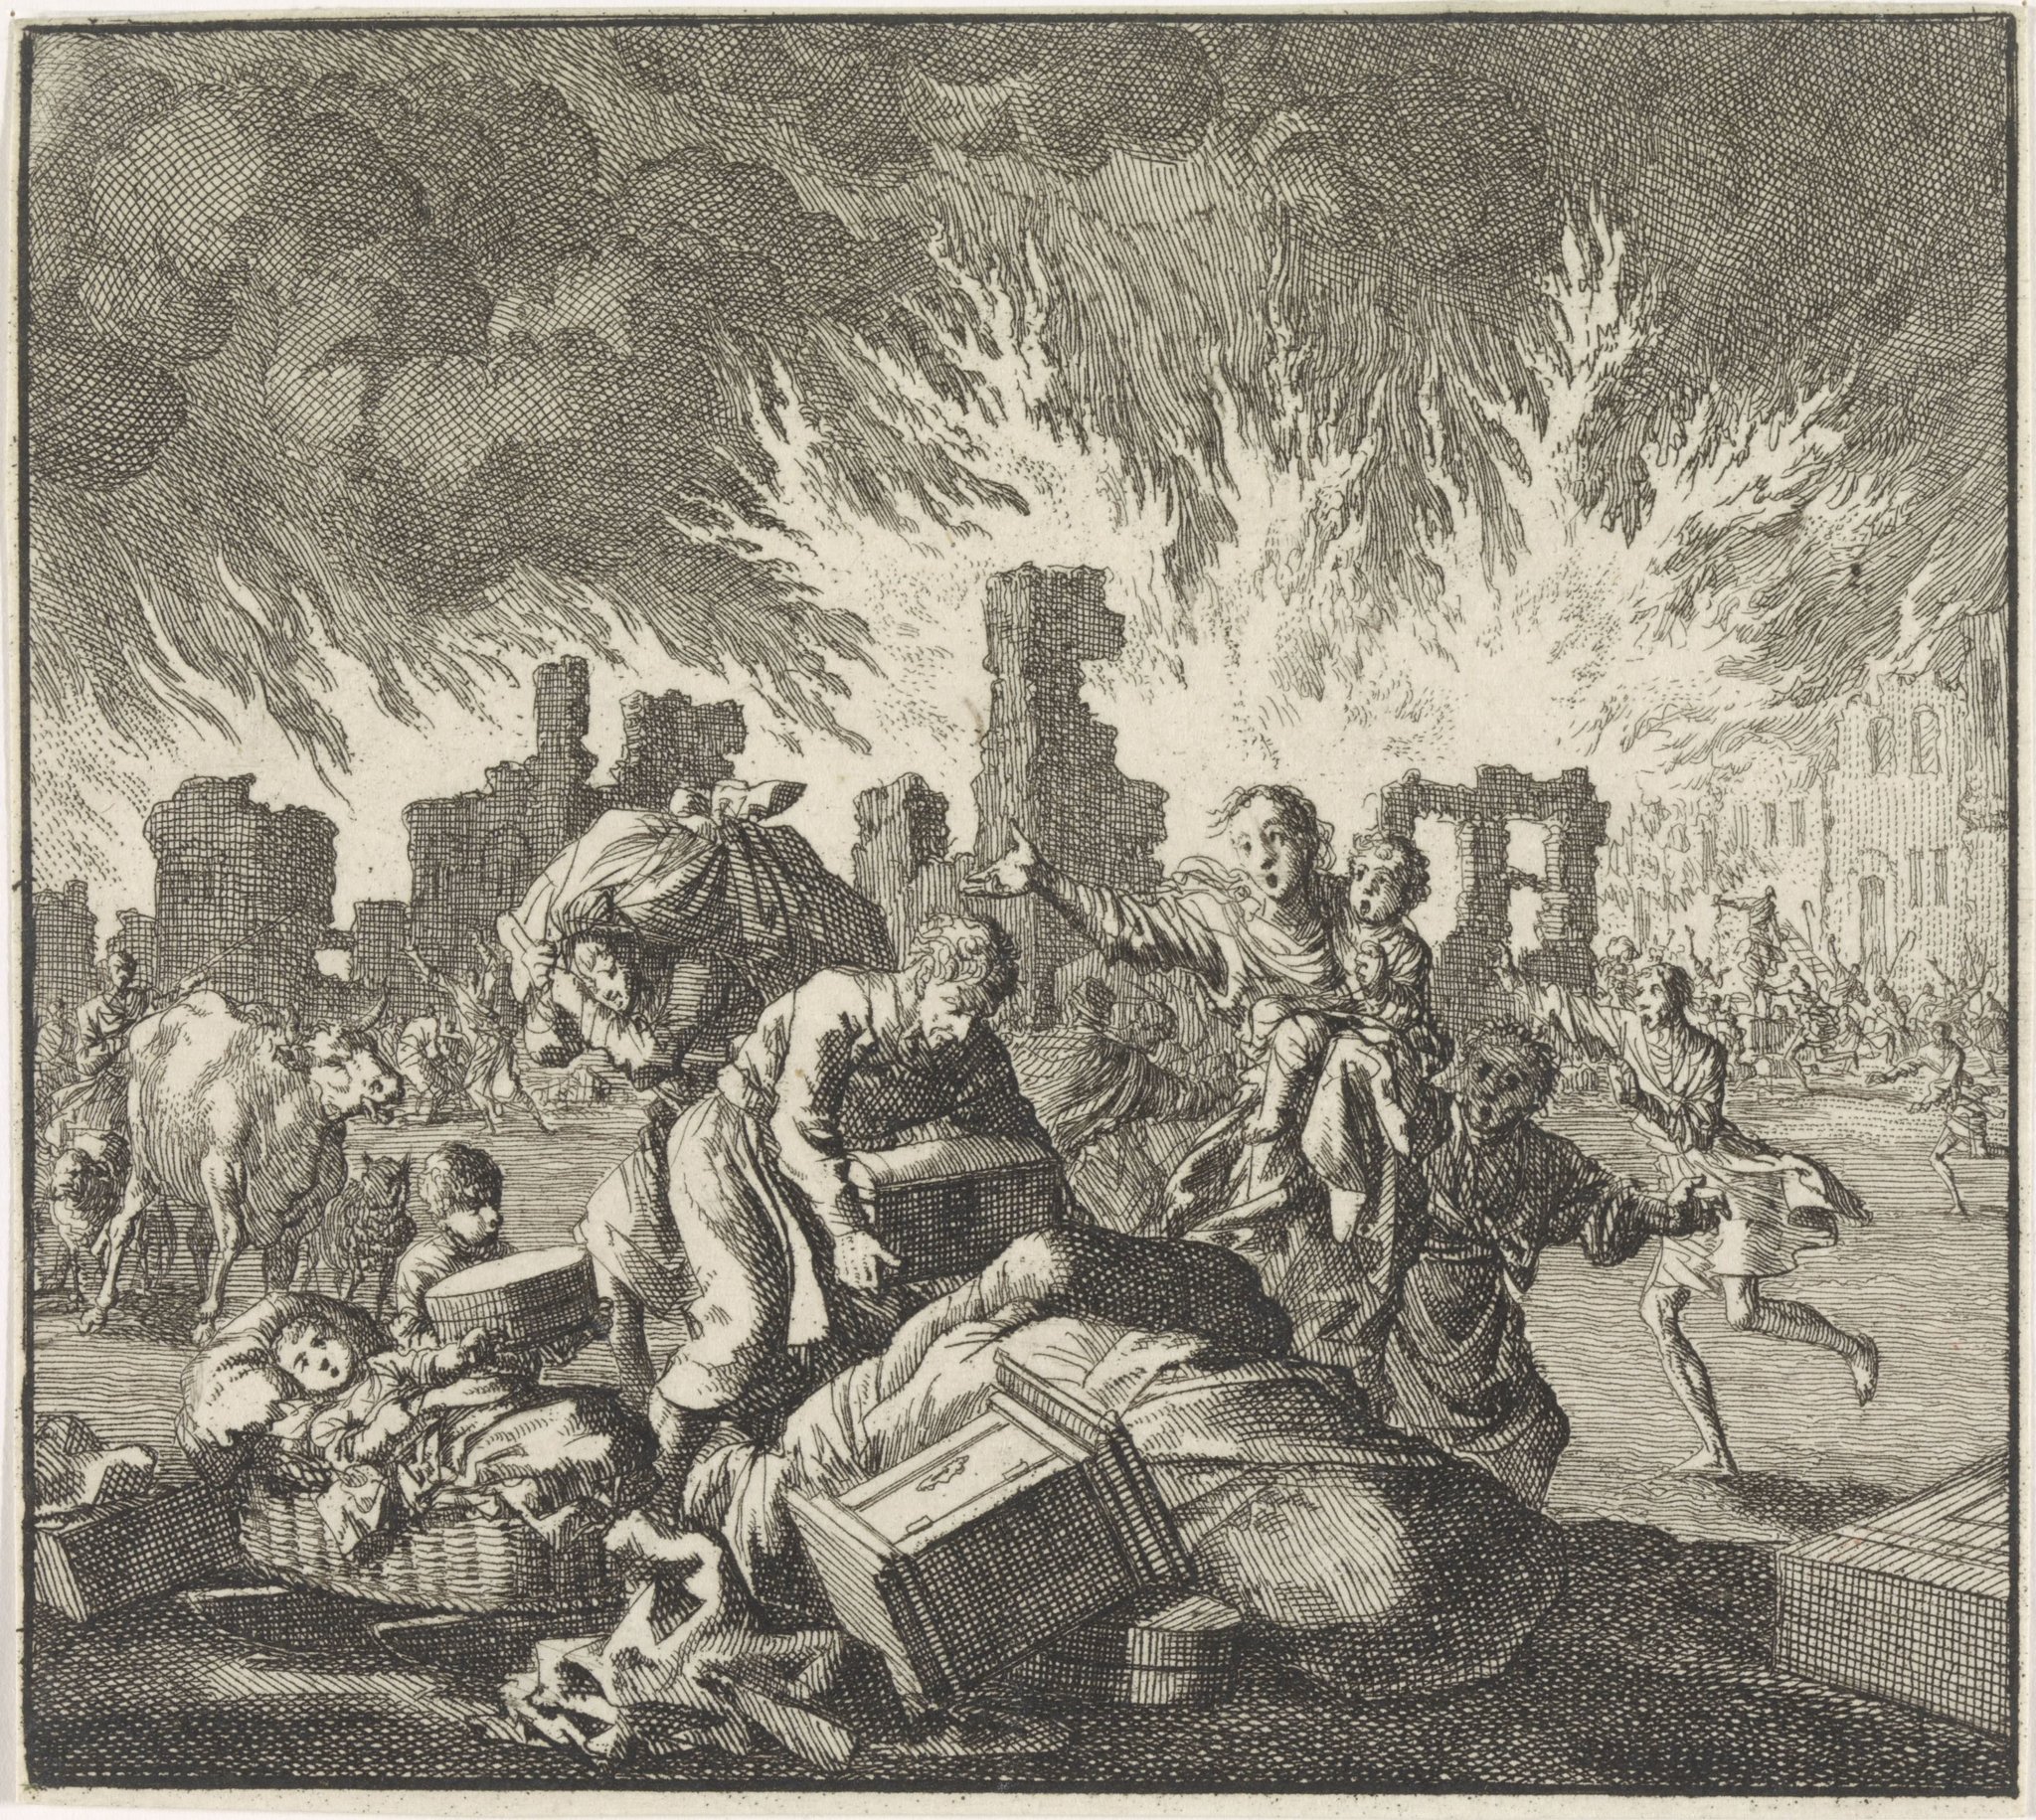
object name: print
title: Brandende stad met vluchtende mensen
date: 1695-1705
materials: paper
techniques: etching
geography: nuremberg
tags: flight, running away; pursuing, setting on fire (of conquered city)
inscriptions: collector's mark: Lugt 240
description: Boekillustratie voor Weigel, Christoph. Ethica Naturalis seu Documenta Moralia e Variis rerum Naturalium proprietatibus Virtutum Vitiorumq symbolicis imaginibus collecta. Neurenberg: Christoph Weigel: c. 1700.